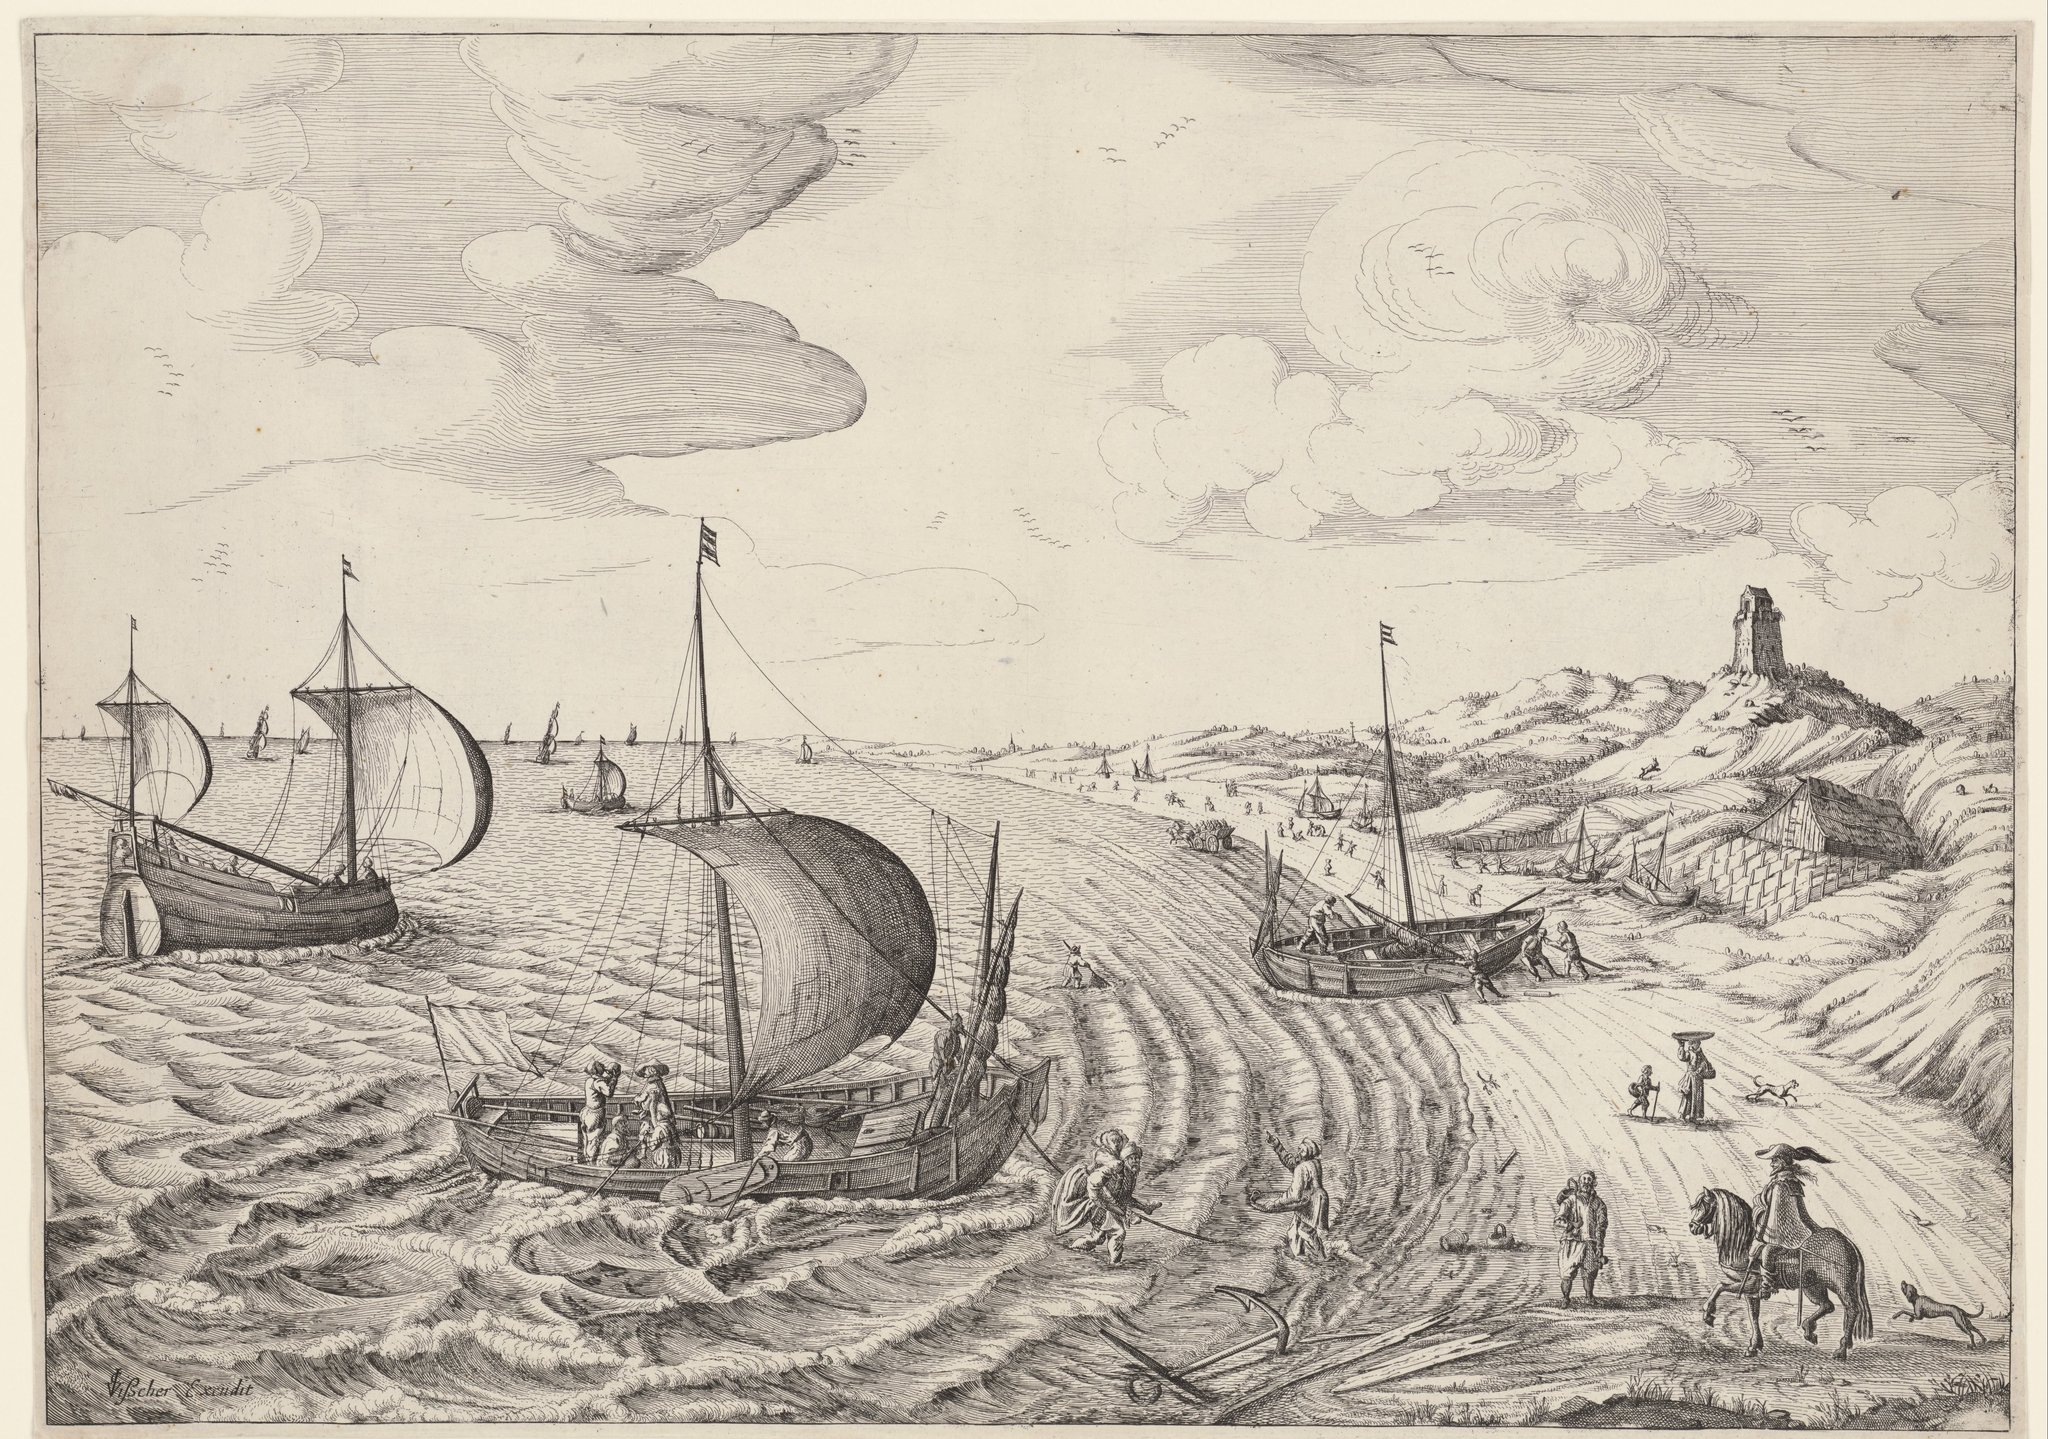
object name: print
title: Coastal Landscape with Fishing Boats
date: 1615-1620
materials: paper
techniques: etching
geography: amsterdam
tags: dune coast, sailing-ship, sailing-boat, carrying a person on one's back, beach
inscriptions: collector's mark: 2760, collector's mark: Lugt 2228, address: ‘CVisscher Excudit’ Lugt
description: Gezicht op een smal strand, met links de zee en rechts de duinen en een vuurtoren. Op de voorgrond de aankomst van een vissersboot. Vanaf de boot wordt een vrouw op de rug van een matroos naar het strand gedragen. Over het strand lopen mensen en rennen honden.